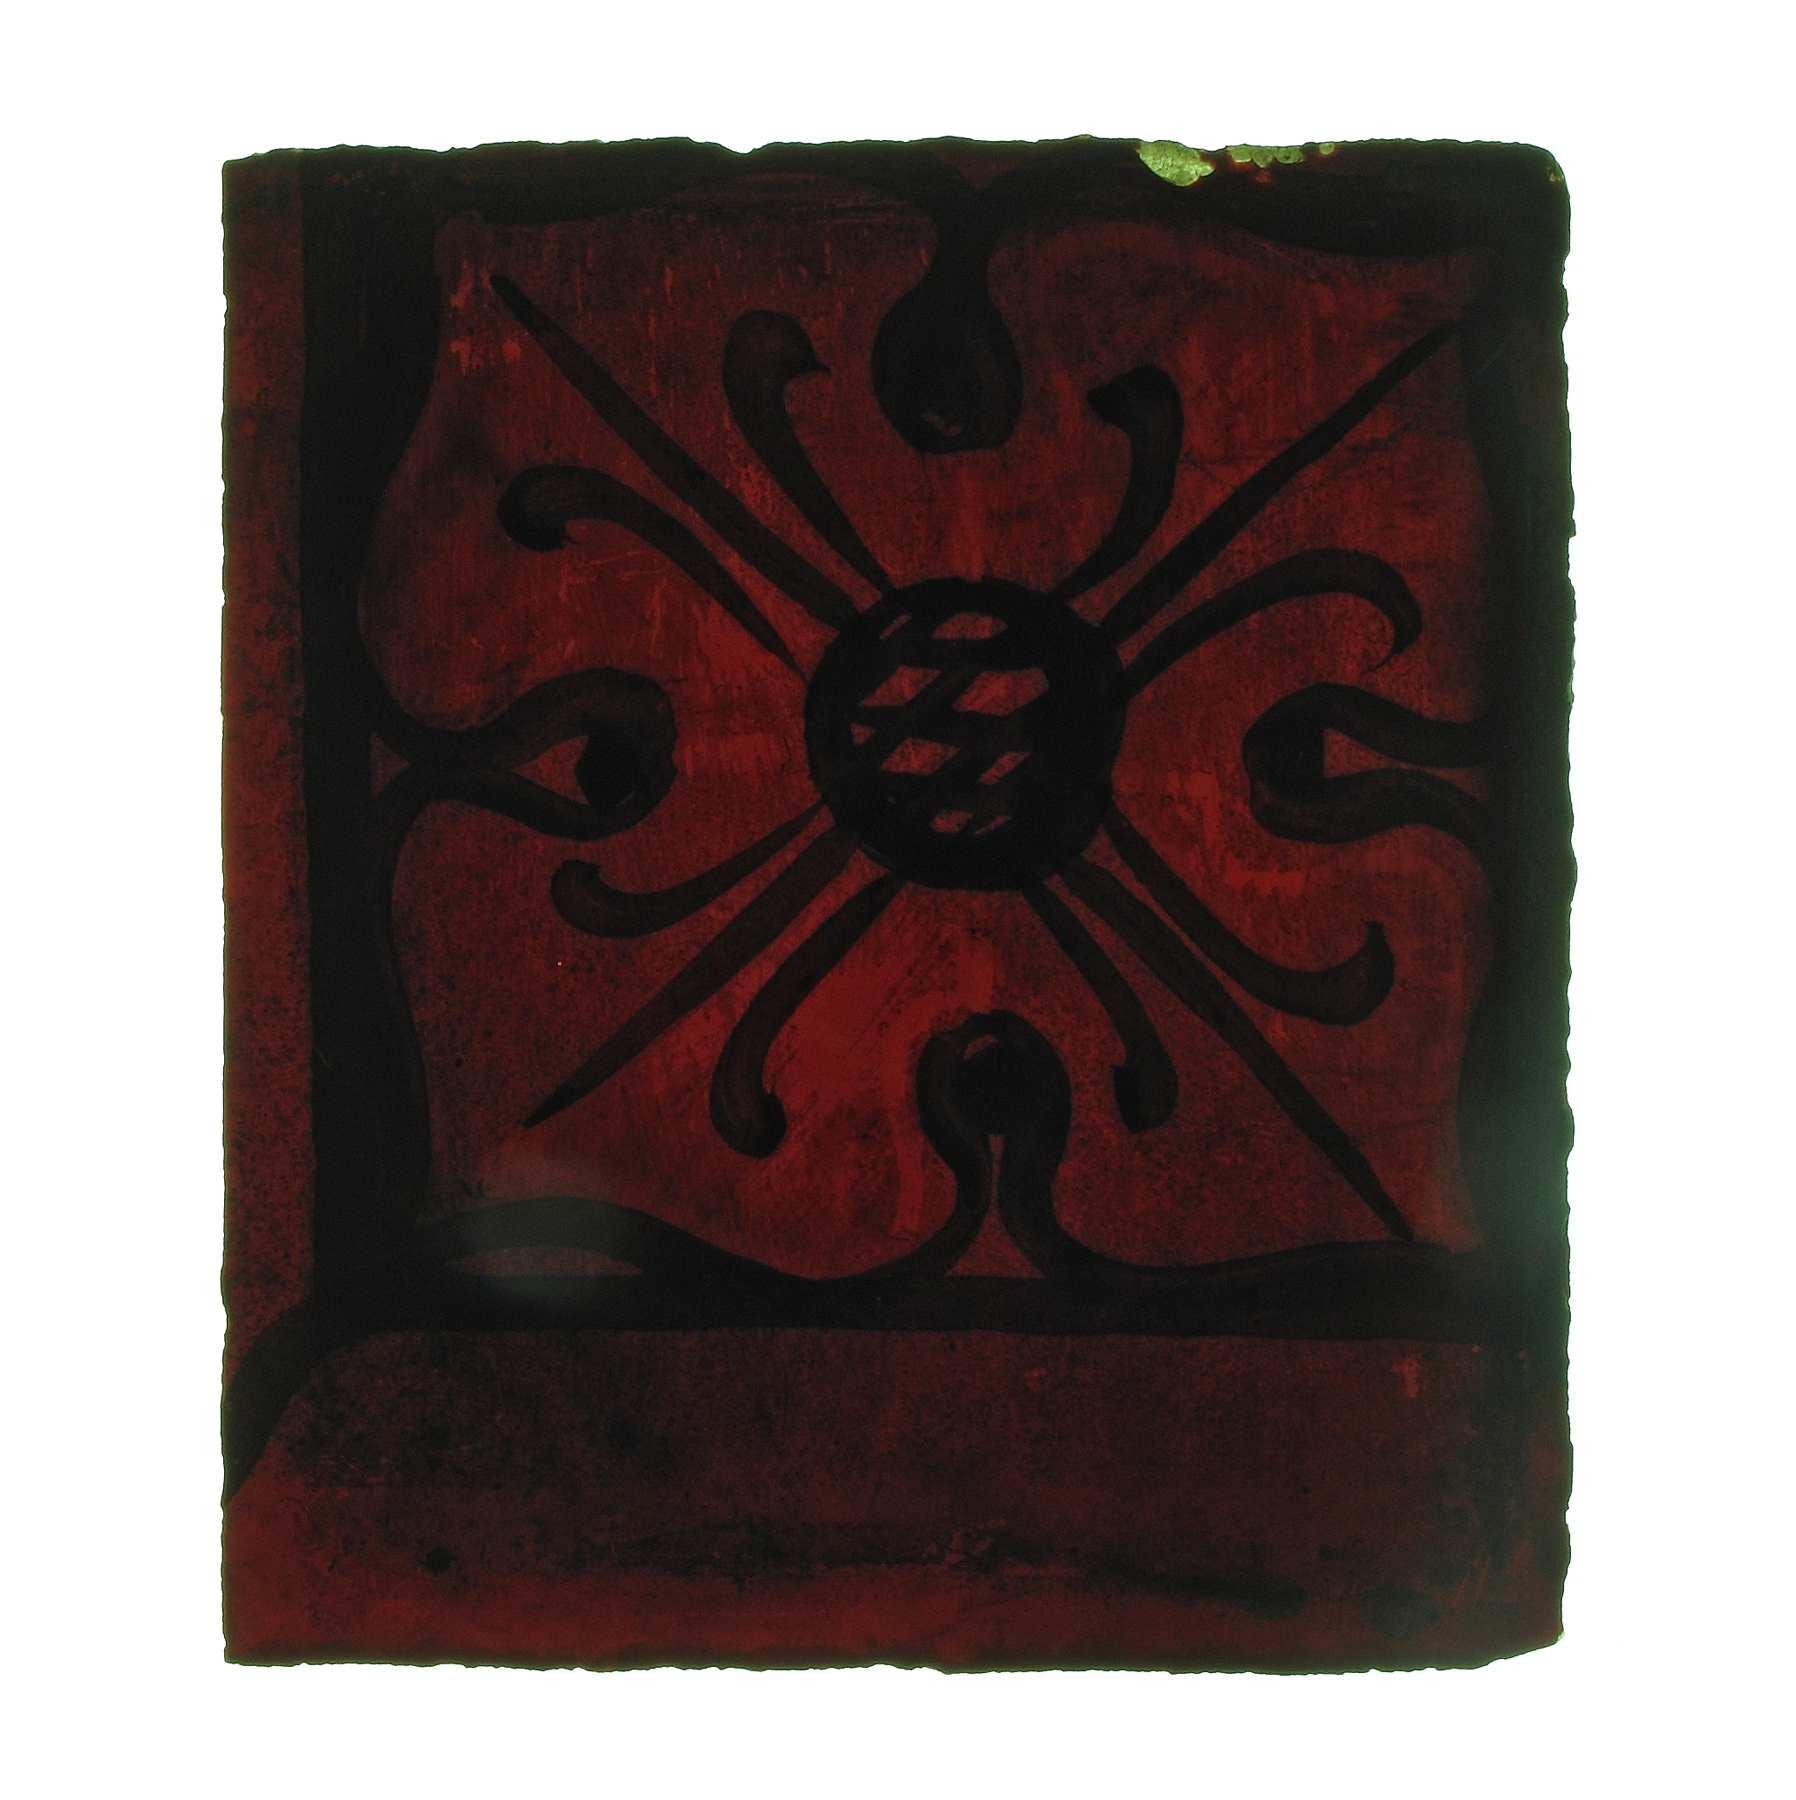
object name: fragment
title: Glass Fragment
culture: european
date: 1801-1900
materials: glass, metal